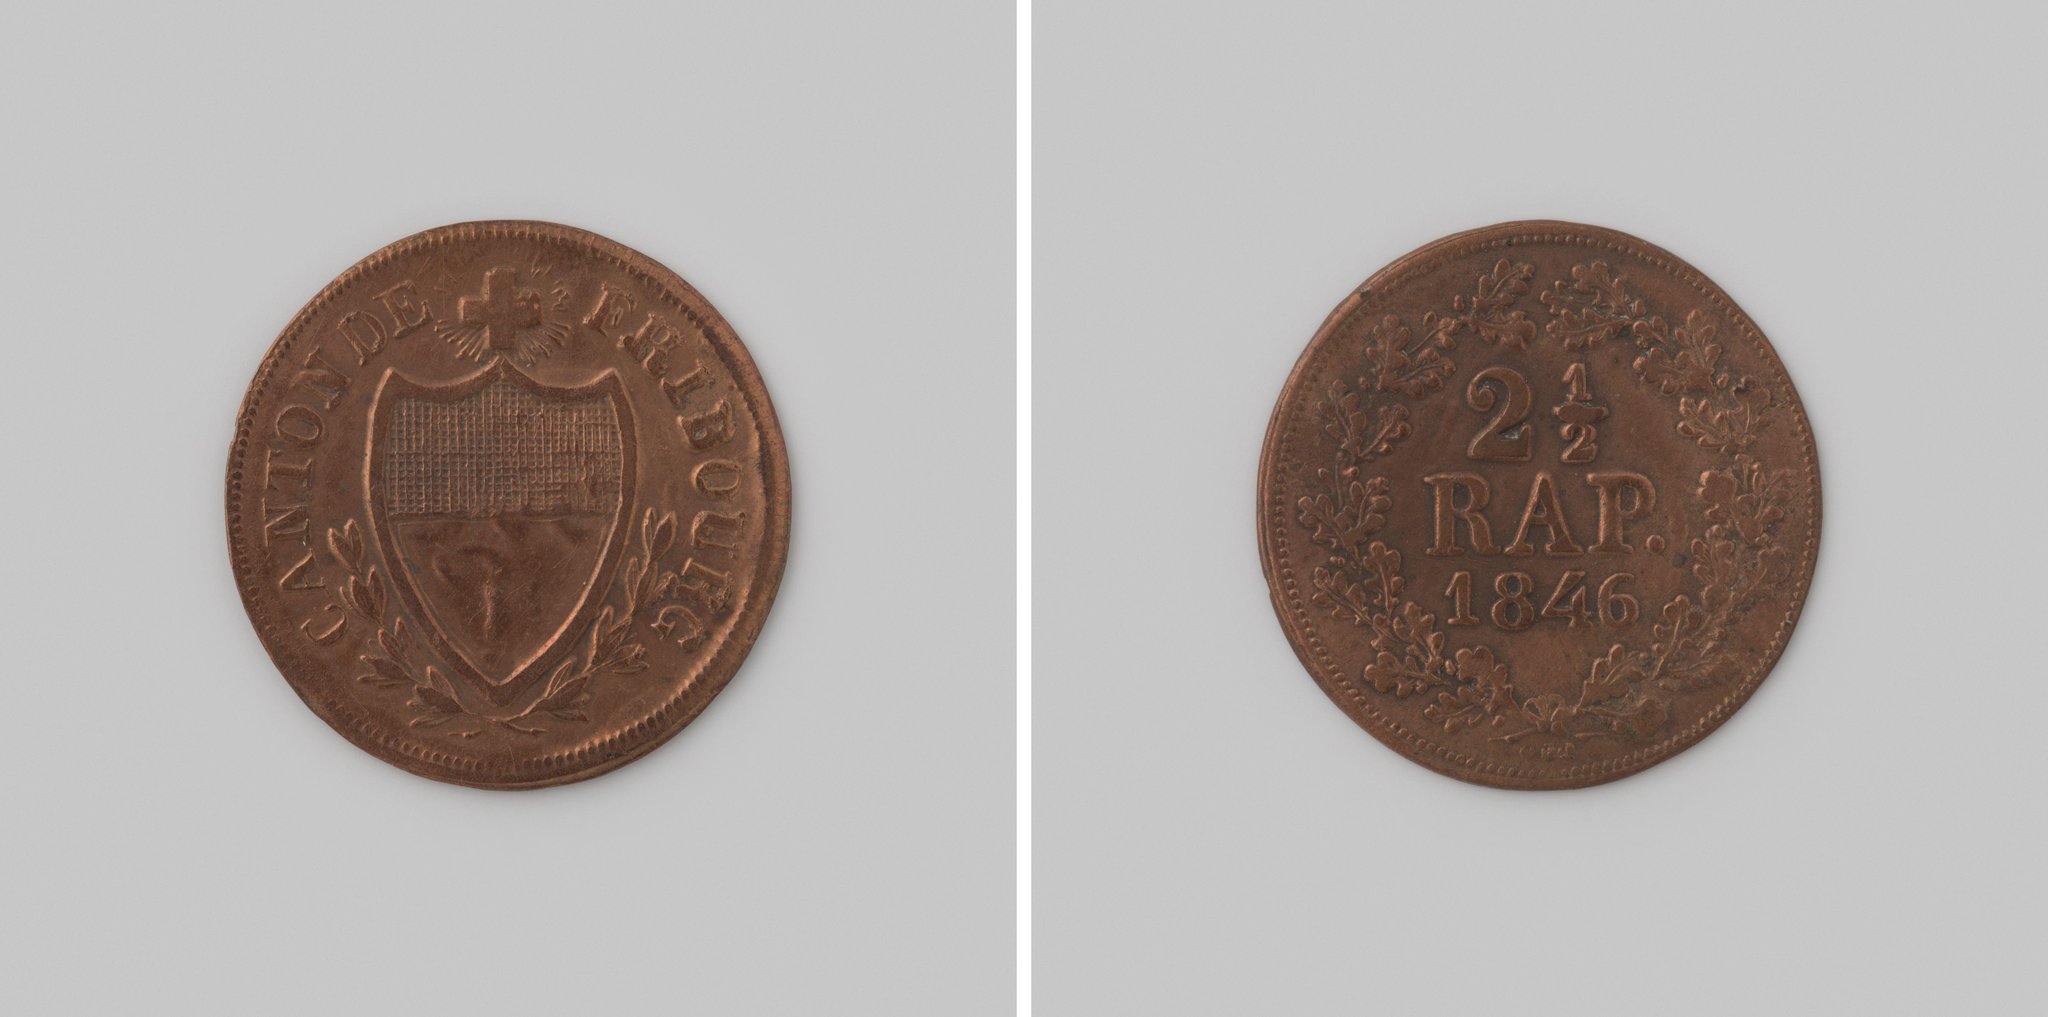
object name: coin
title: Kanton Fribourg, 2½ rappe, 1846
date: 1846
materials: copper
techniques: striking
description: Koperen munt. Voorzijde: tussen twee takken wapenschild, waarboven door stralen omringd kruis. Keerzijde: binnen twee samengebonden takken waarde-aanduiding: 2½ rap. in twee regels, waaronder jaartal. Gladde rand.